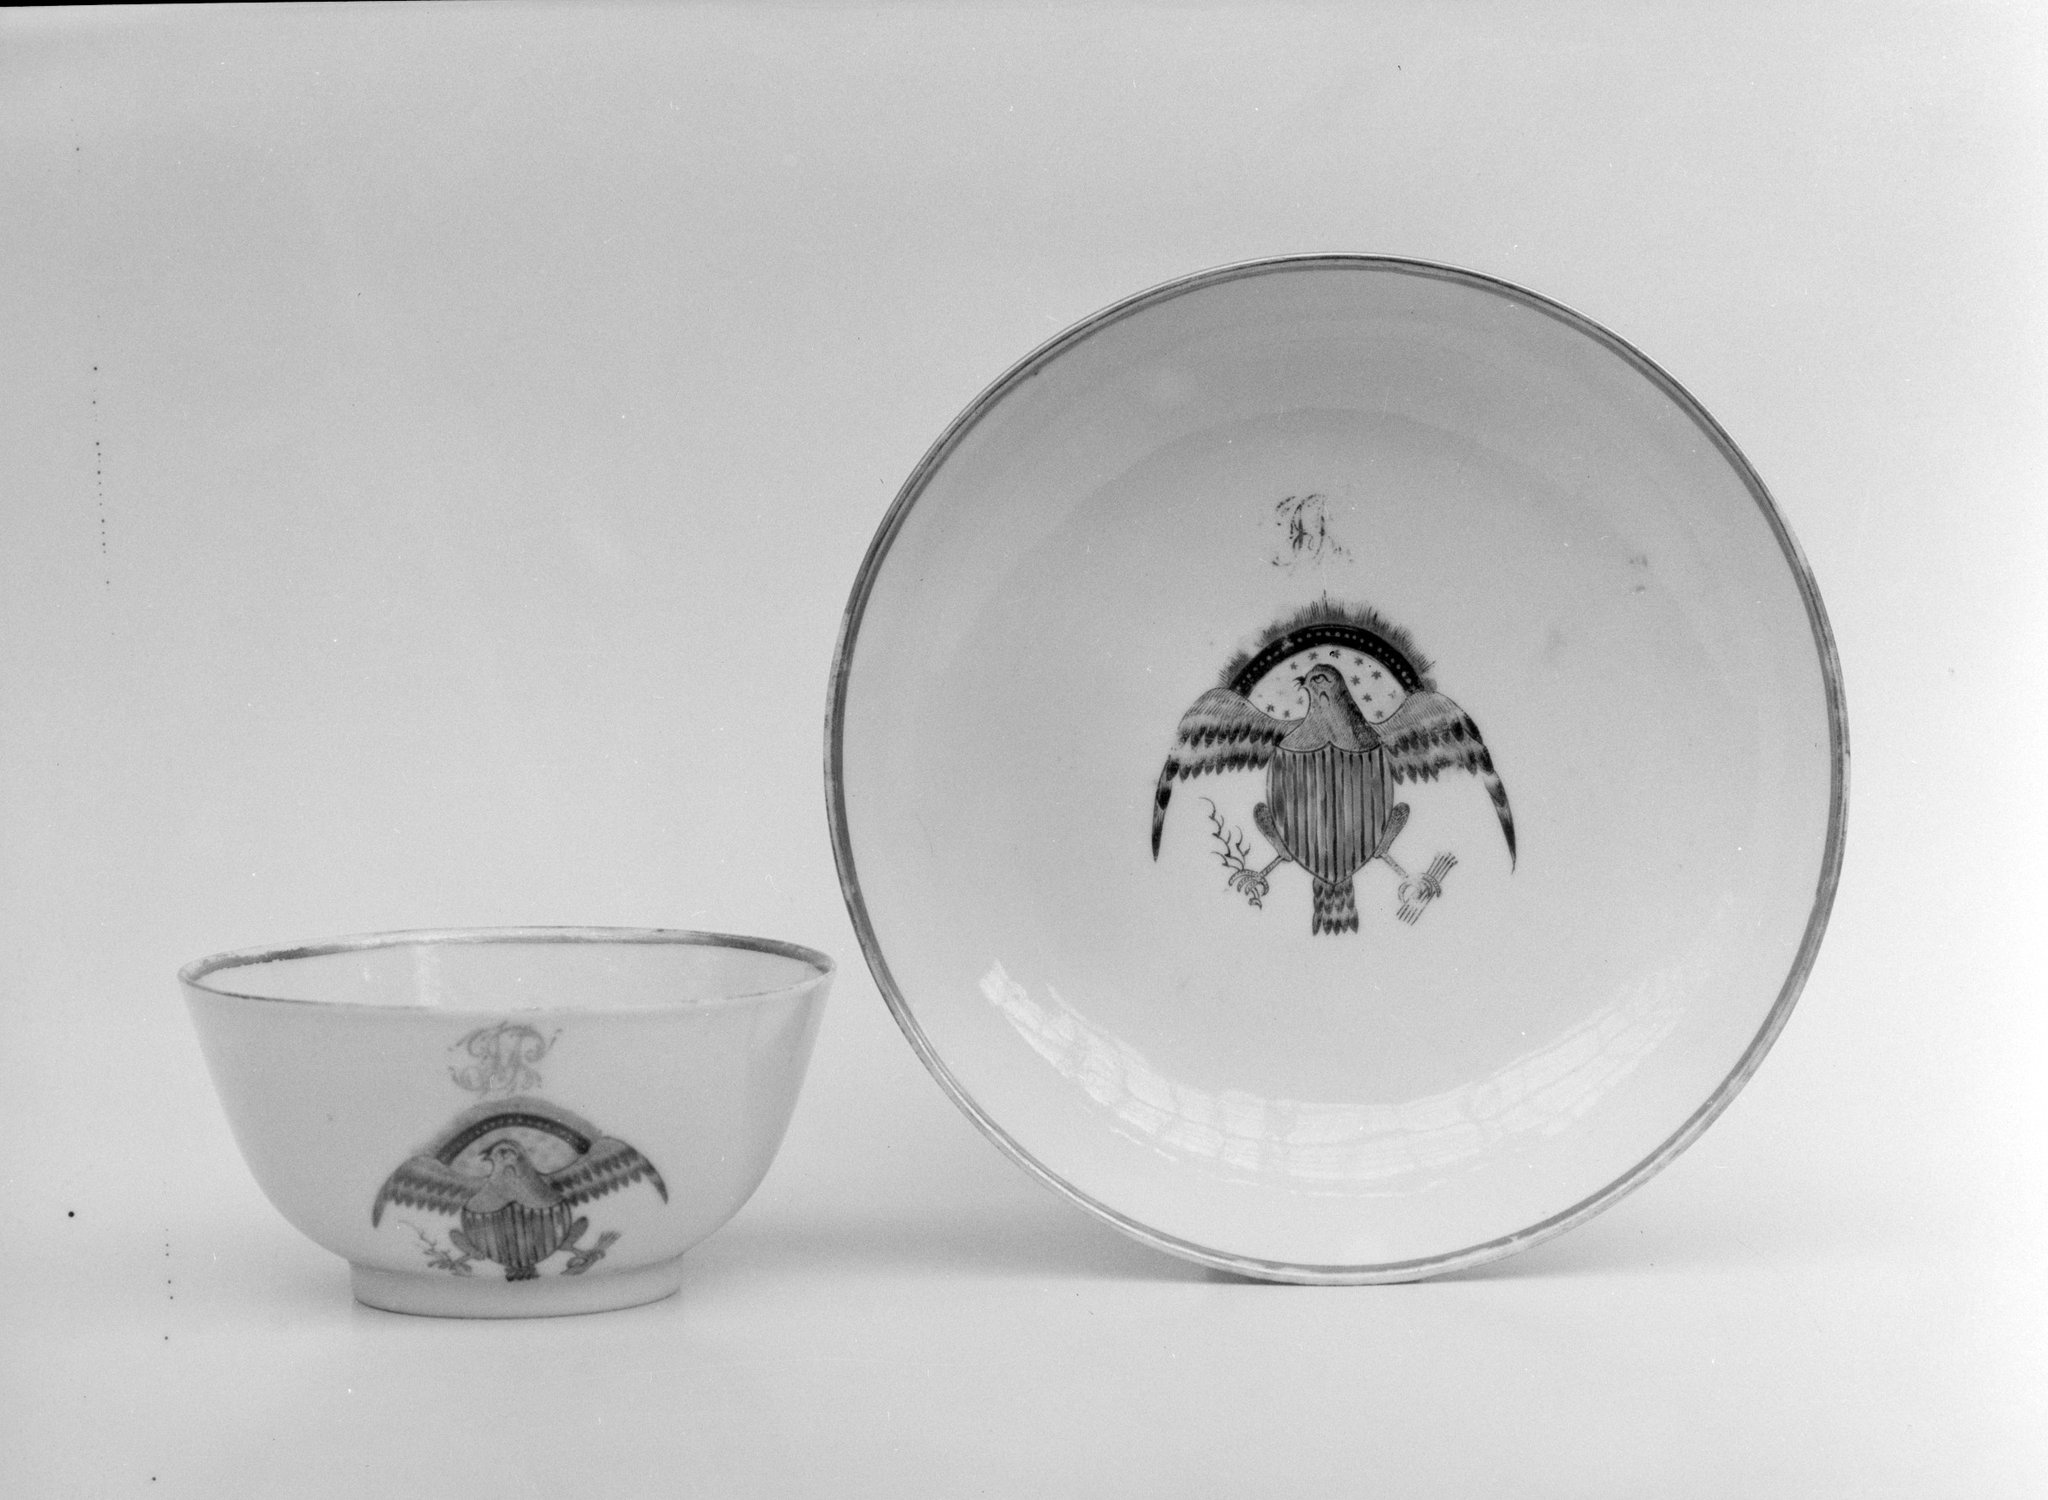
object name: cup and saucer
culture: chinese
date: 1853-1857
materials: porcelain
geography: china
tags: eagles